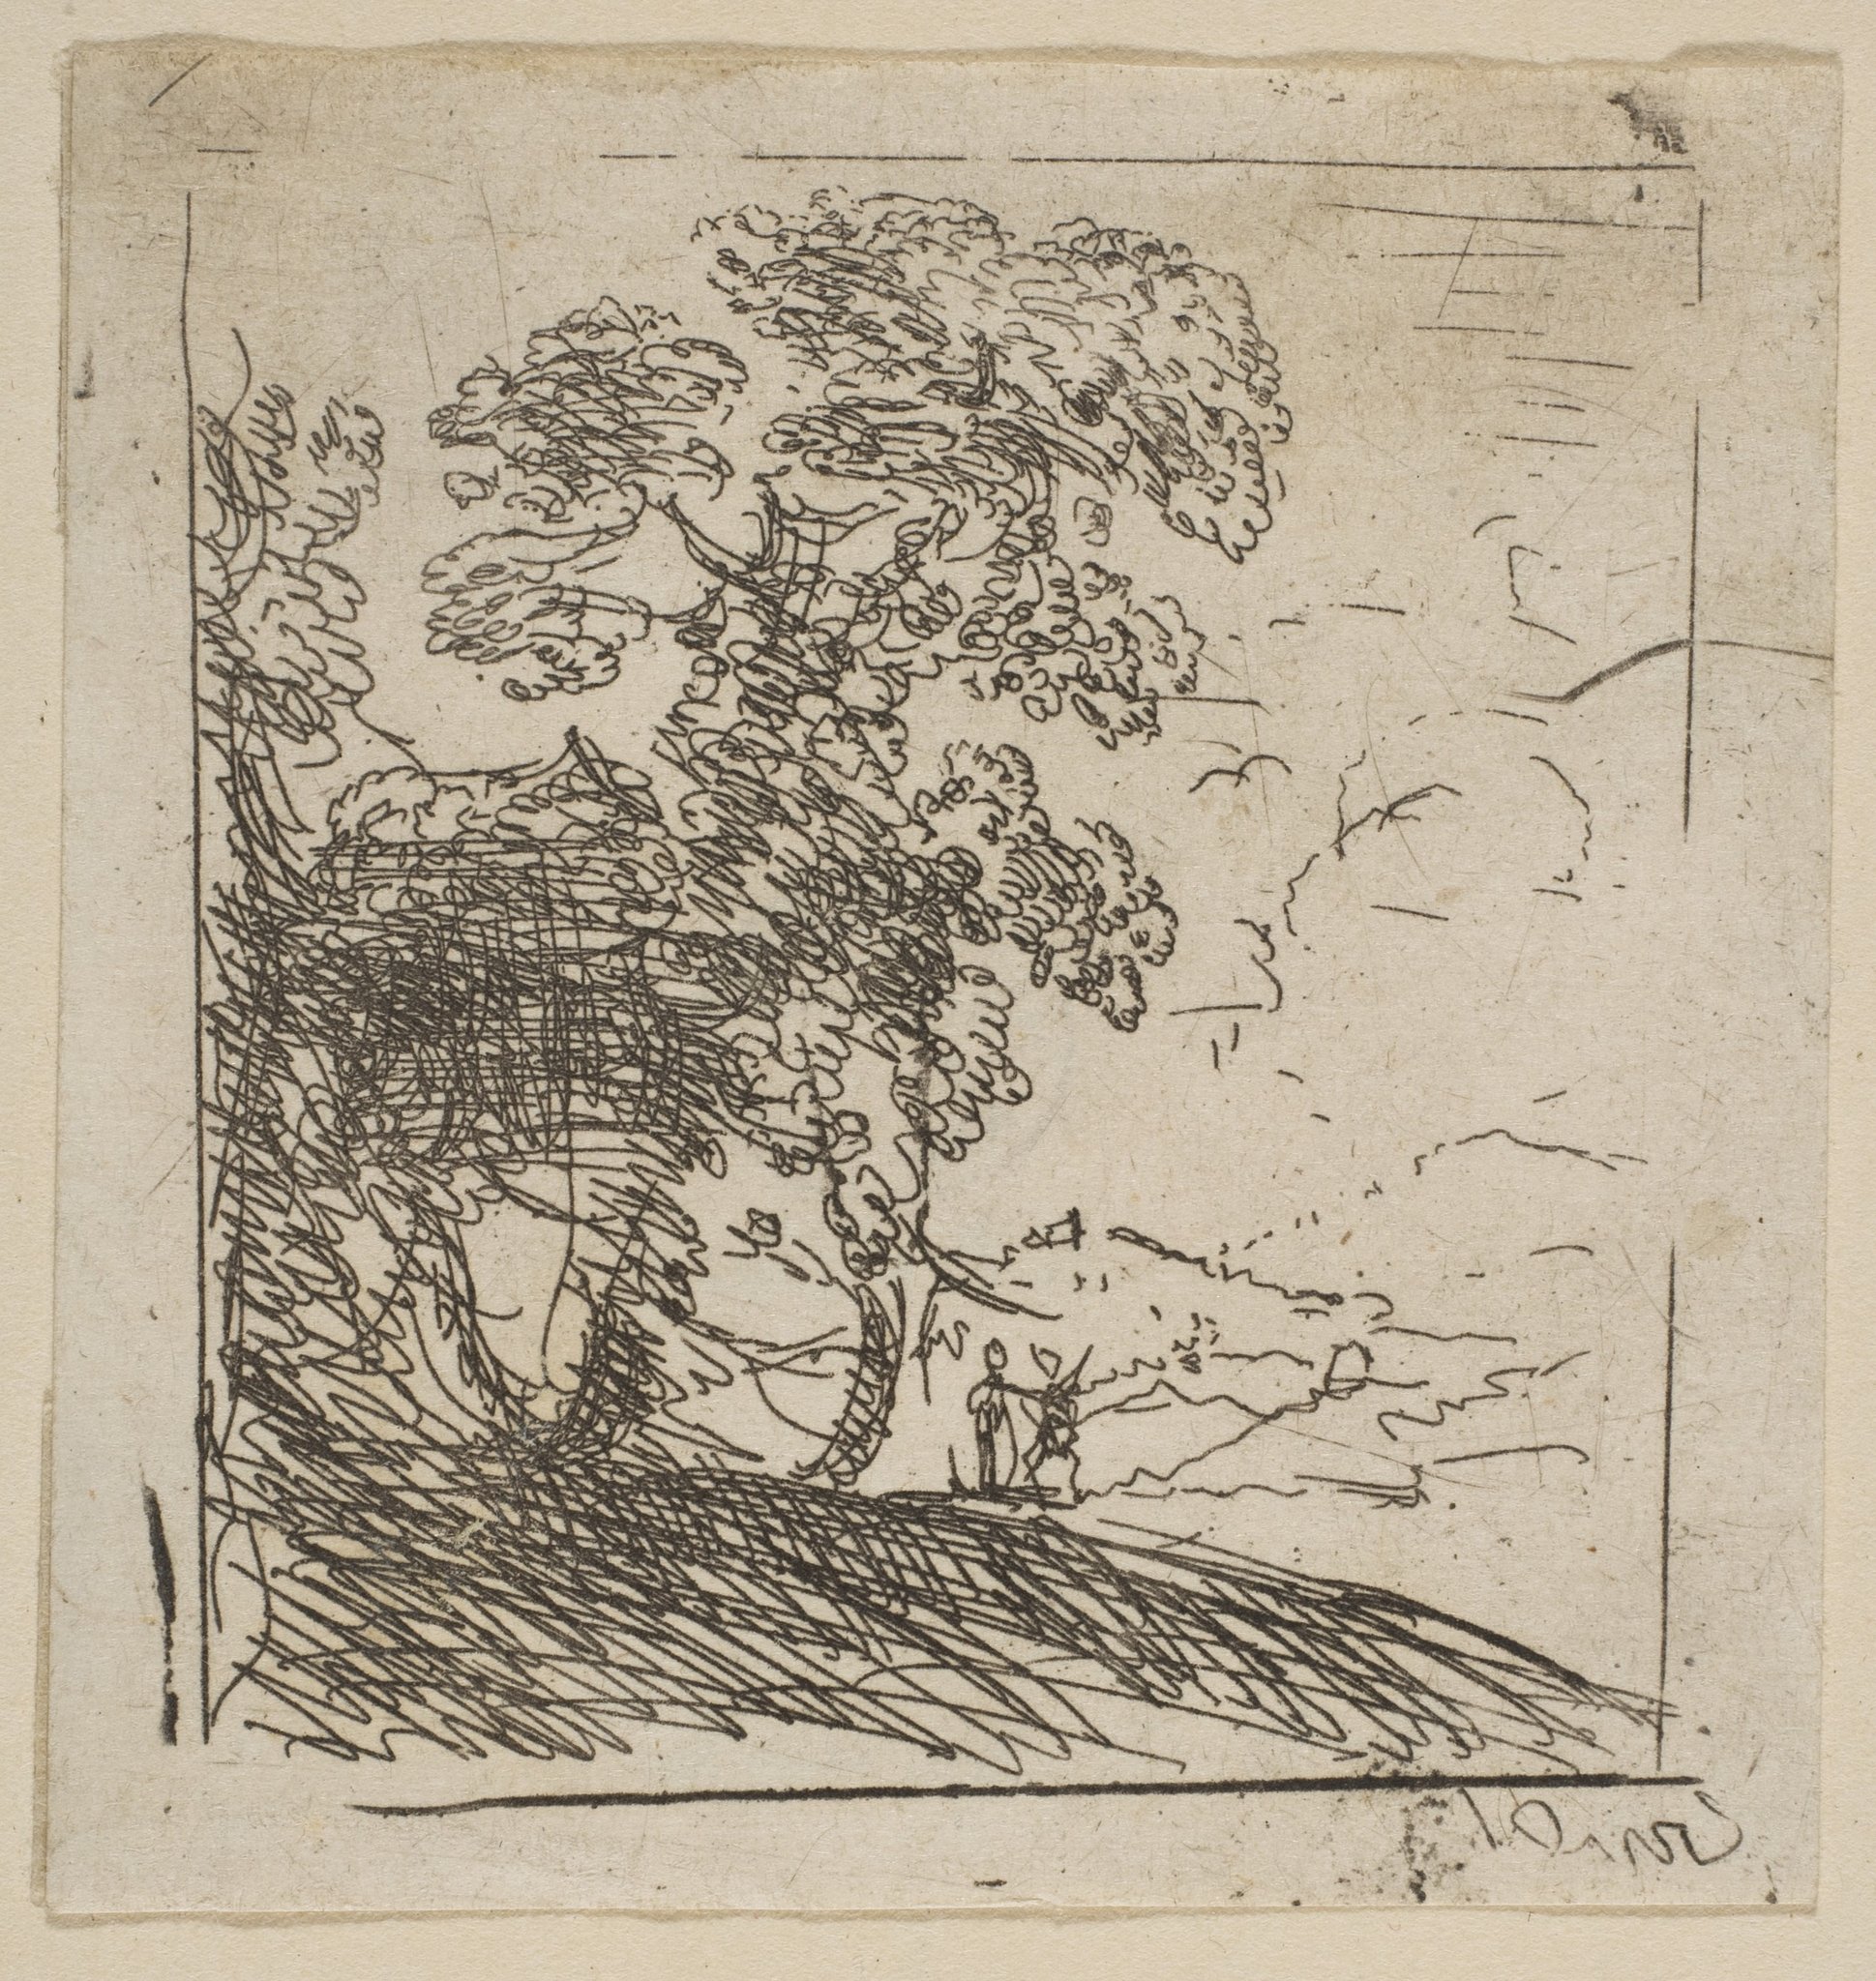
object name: print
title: The Two Landscapes (Right Tree)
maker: claude lorrain (claude gellée)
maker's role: artist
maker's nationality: french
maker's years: 1604-1682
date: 1630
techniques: etching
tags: human figures,landscapes,trees